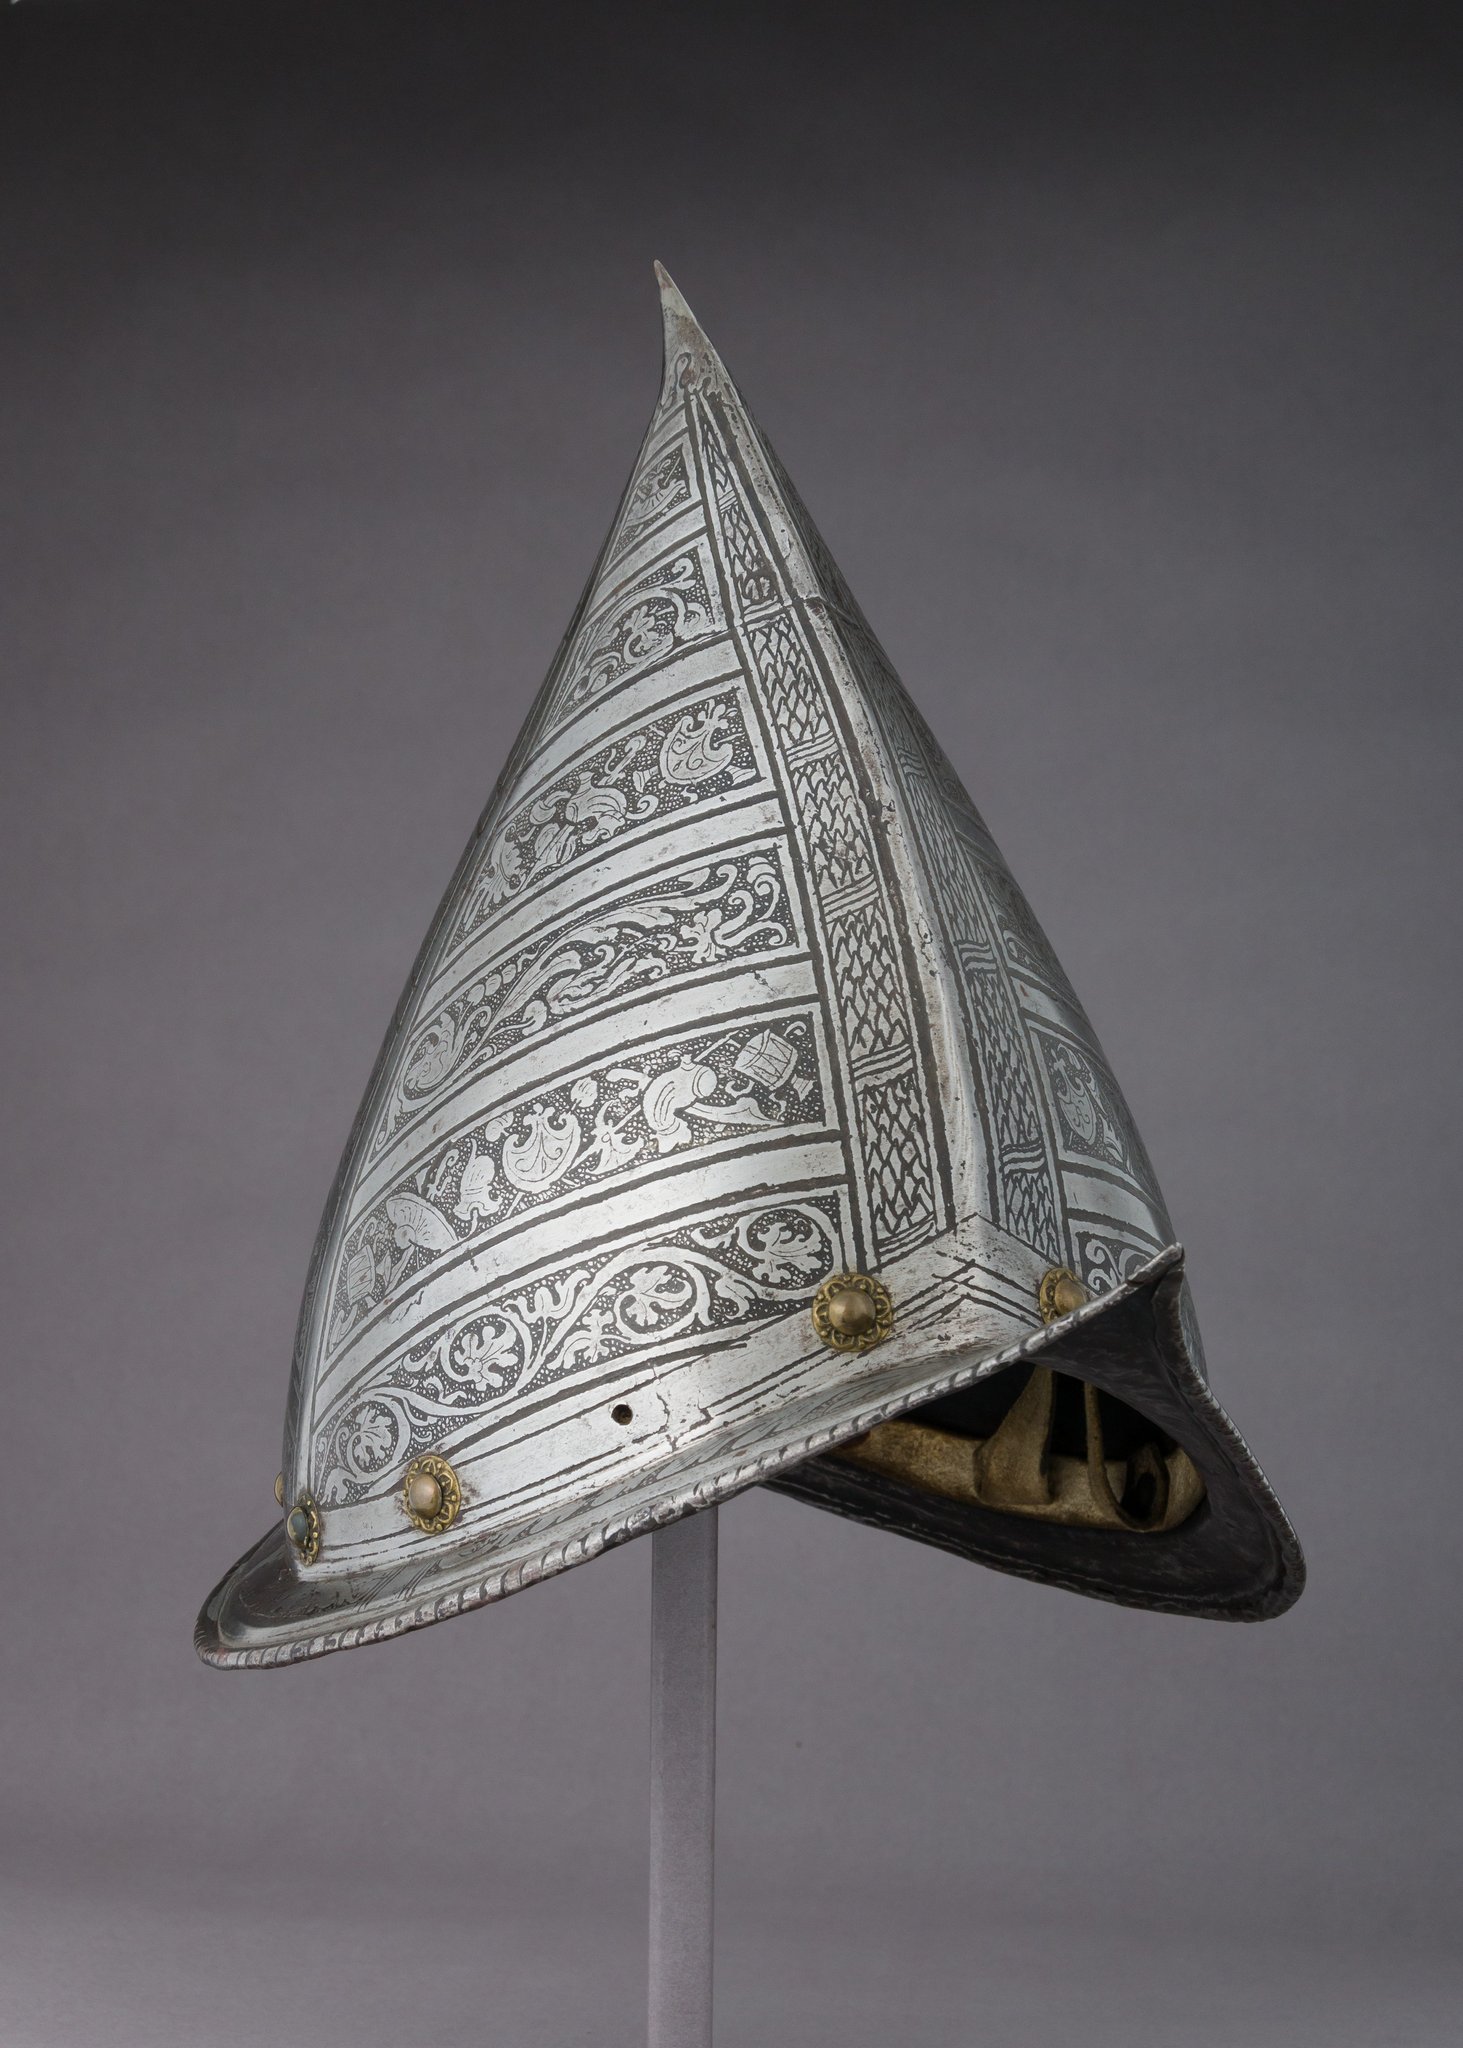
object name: morion cabasset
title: Morion-Cabasset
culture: italian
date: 1575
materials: brass, leather, steel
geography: italy